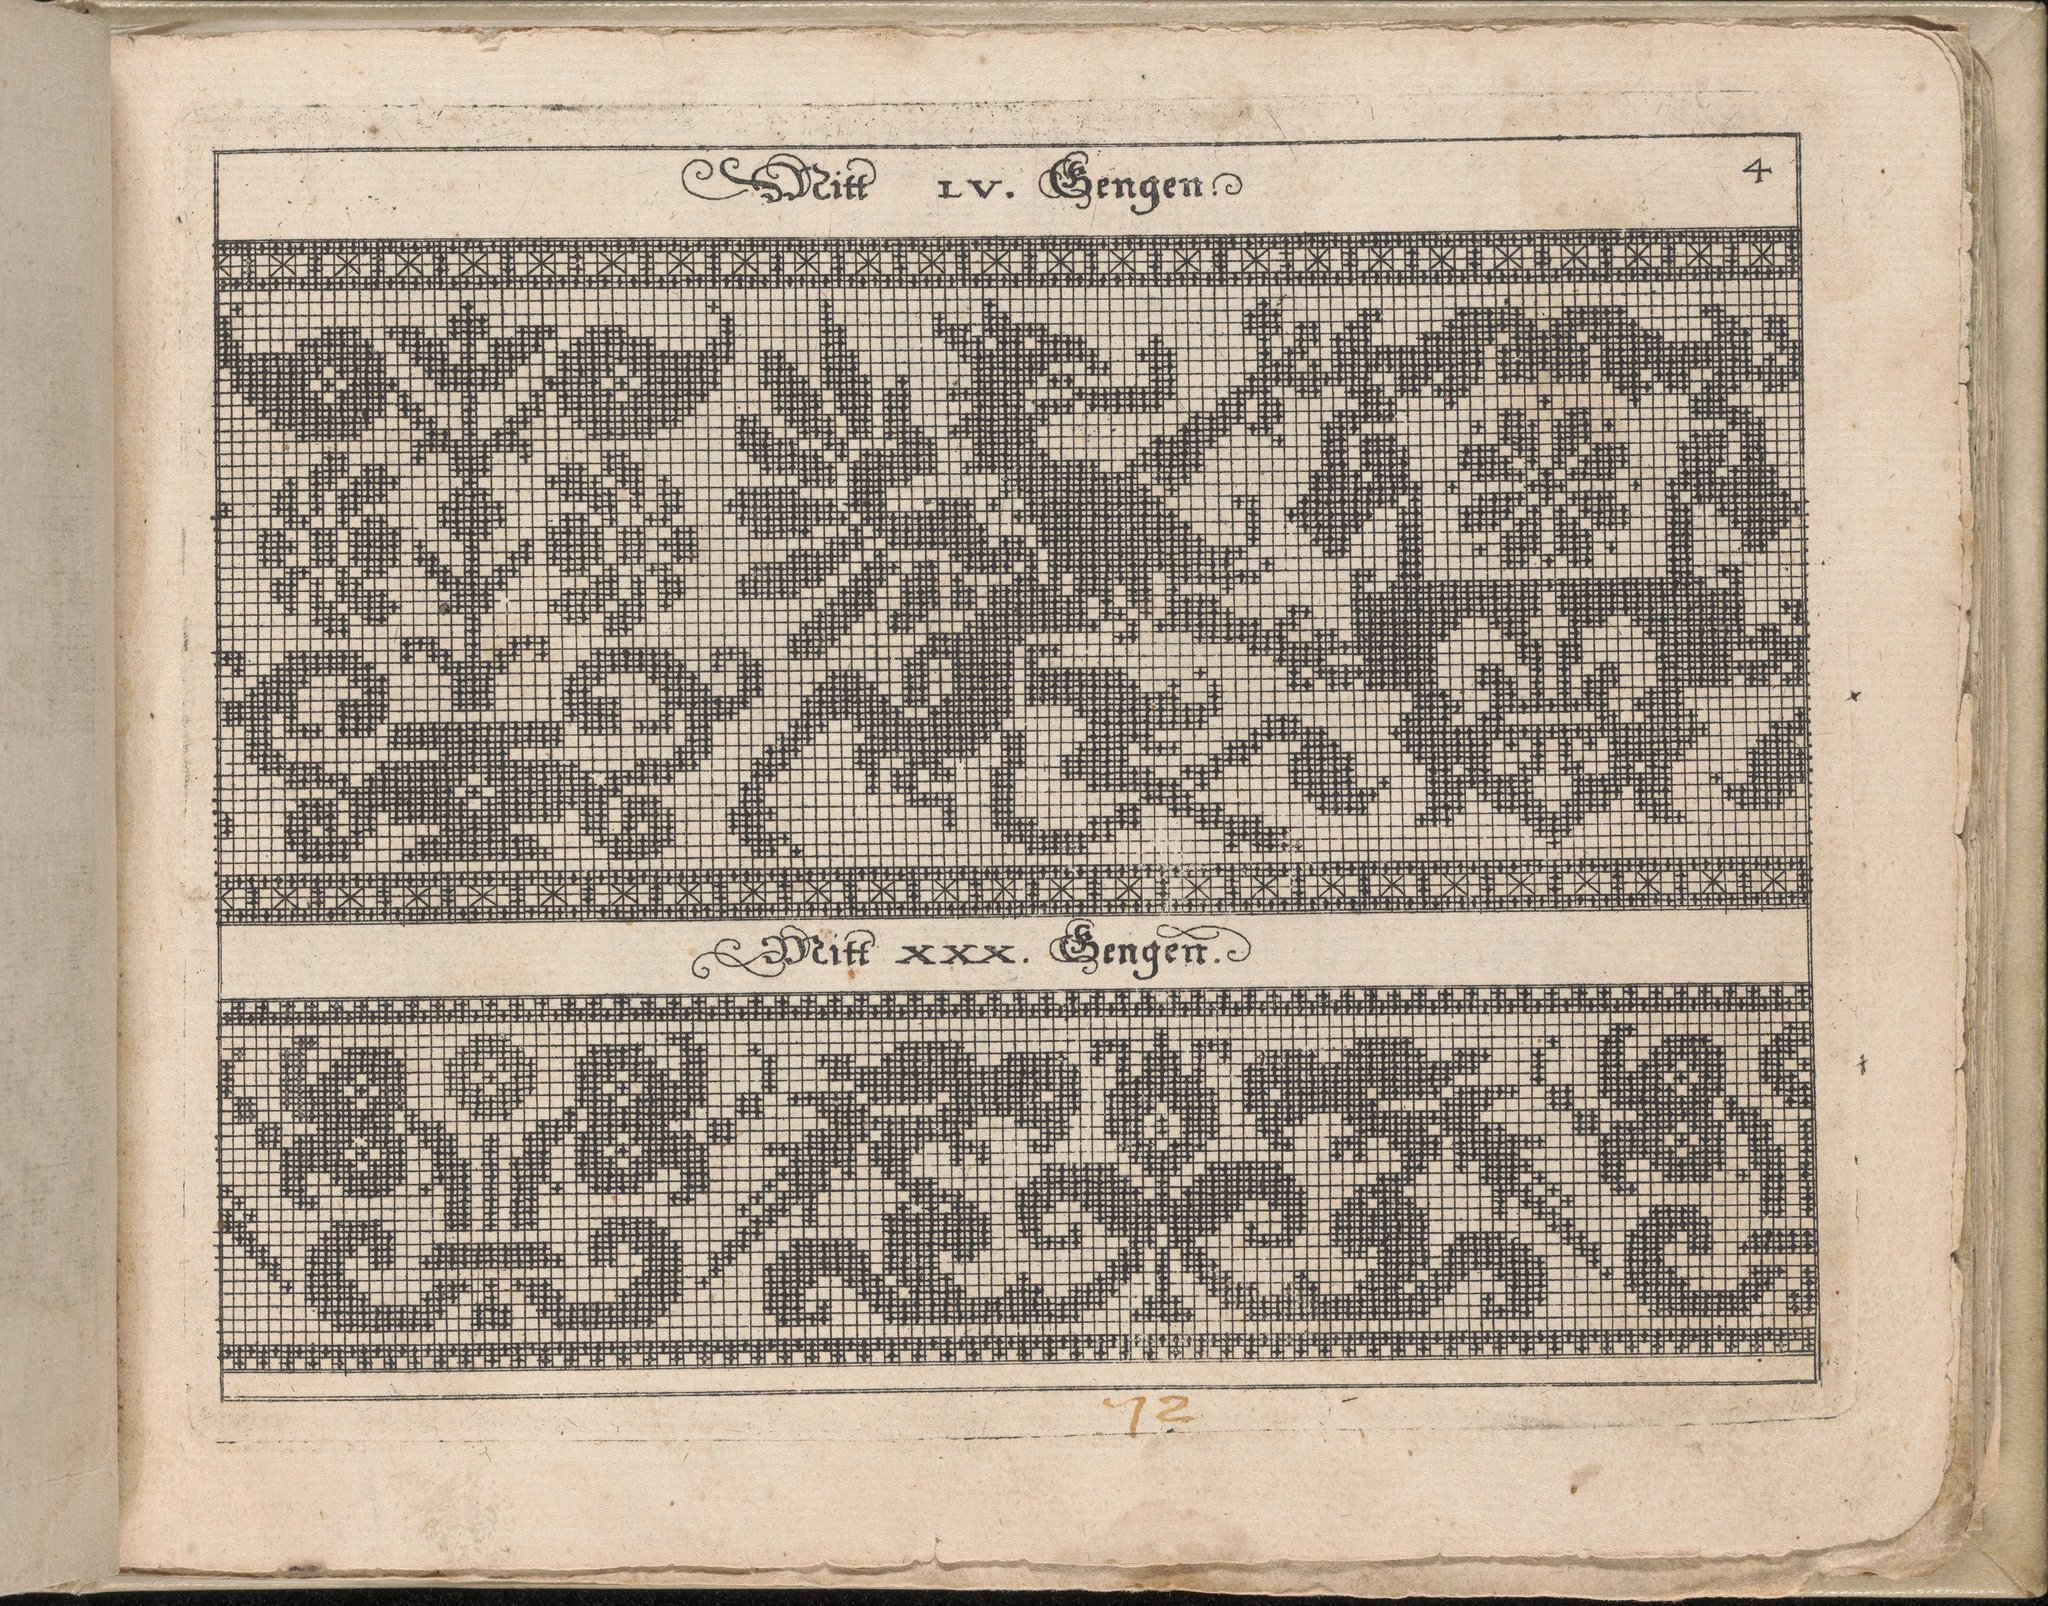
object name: book print ornament architecture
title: Schön Neues Modelbuch (Page 9 recto)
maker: johann sibmacher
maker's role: designer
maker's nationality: german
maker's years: 1590-1611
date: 1597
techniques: etching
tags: birds